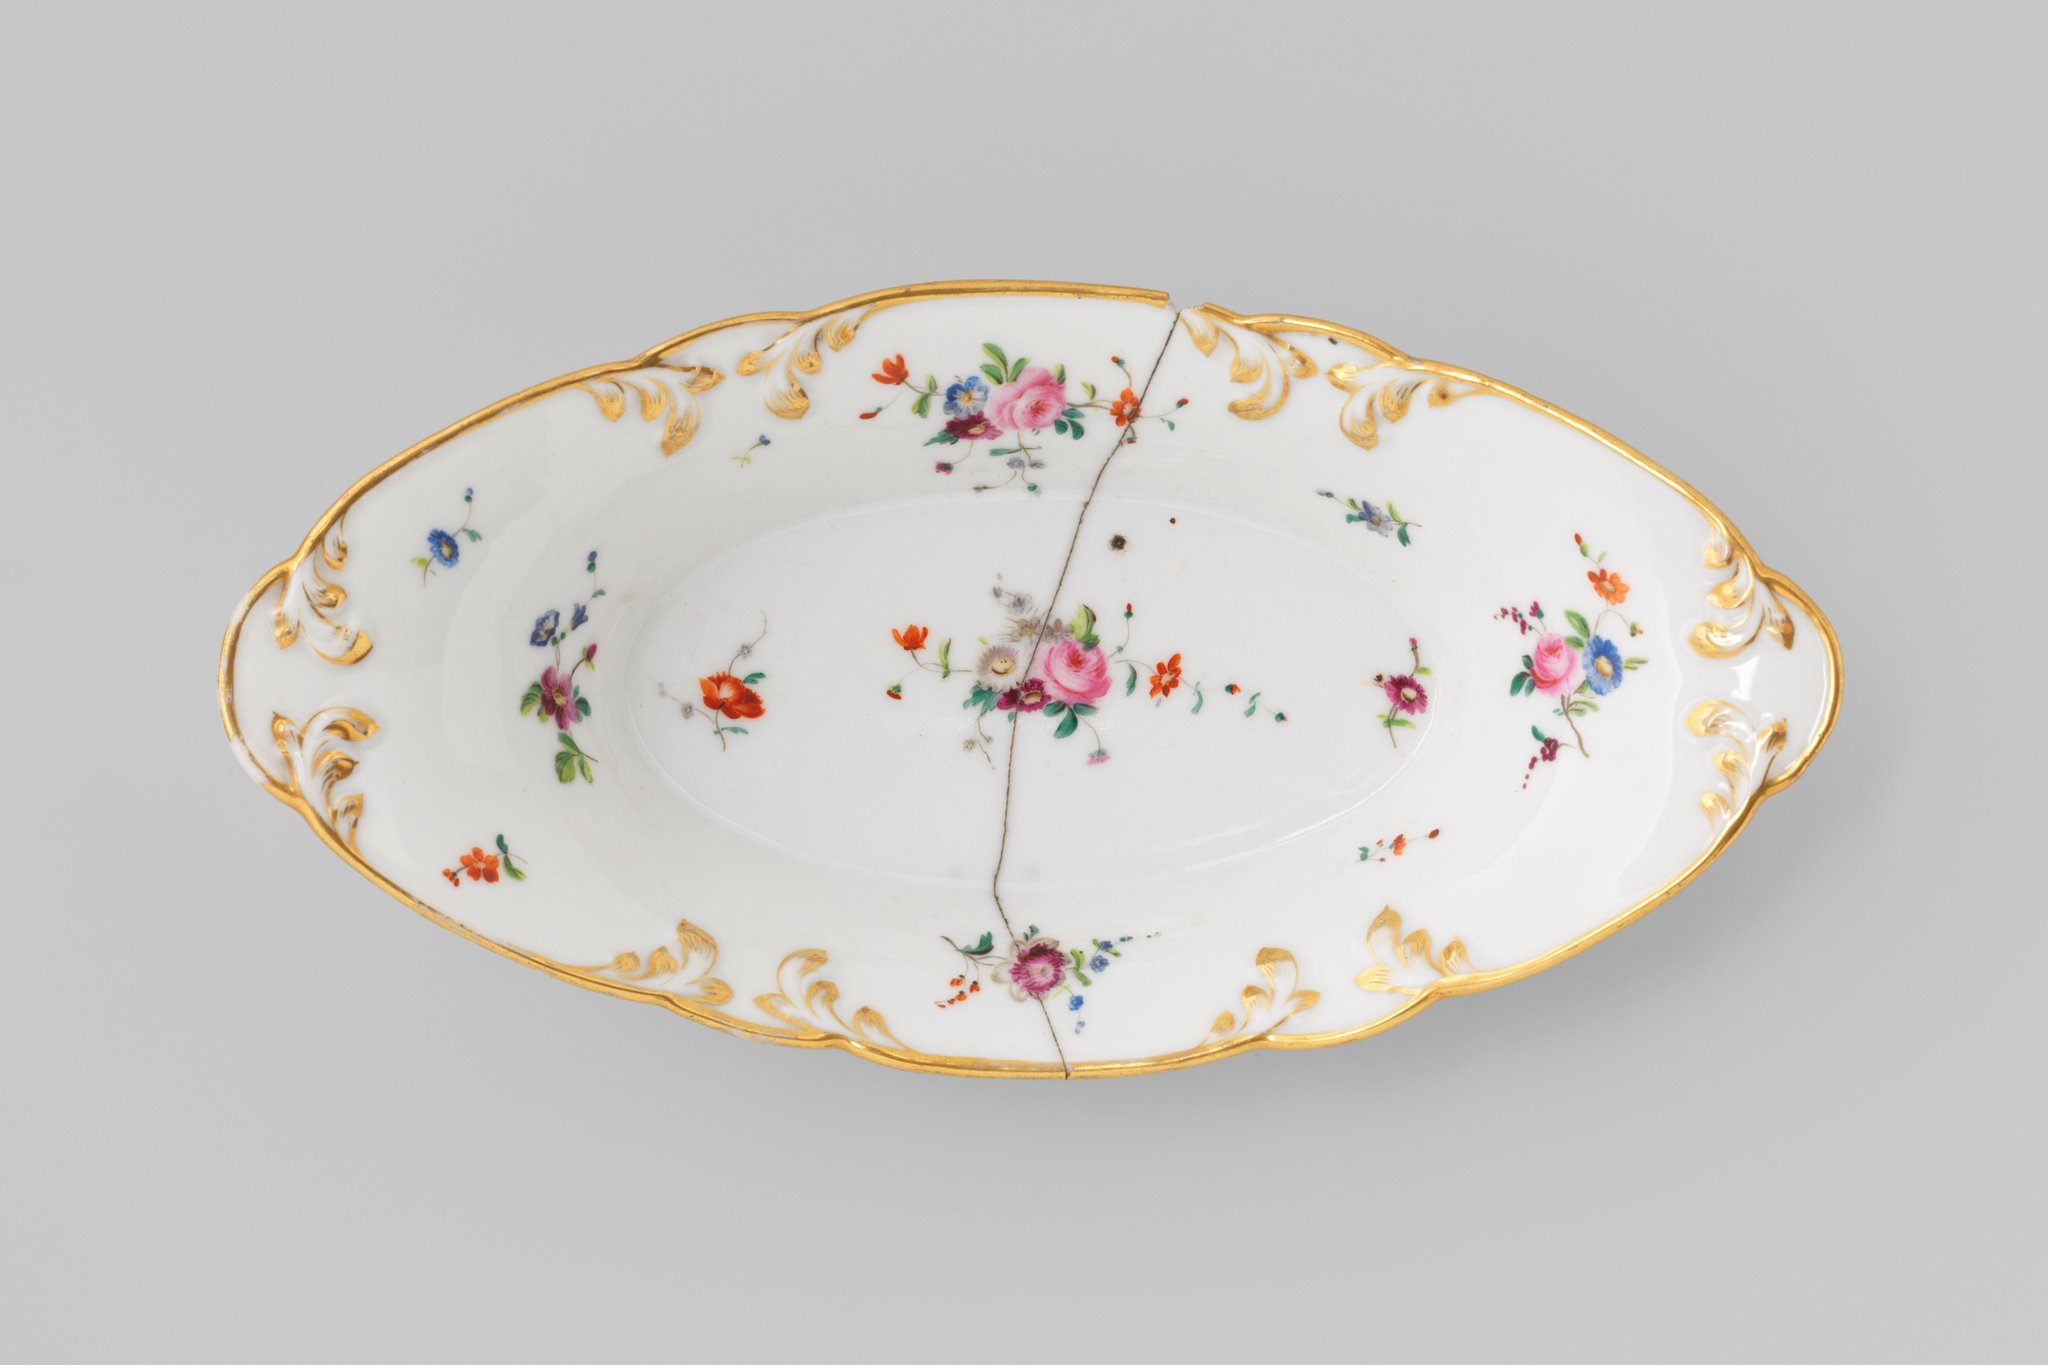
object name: service set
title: Dish with bouquets and flower sprays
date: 1839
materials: glaze, gold, paint, porcelain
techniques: firing, forming, gilding, turning, vitrification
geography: paris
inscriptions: mark: ‘DENUELLE/ Boulevard St. Denis 18/ à Paris’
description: Ovale schaal van porselein met een gelobde rand en de uiteinden spits toelopend, beschilderd op het glazuur in blauw, rood, roze, groen, geel, paars, zwart en goud. Op het plat, de binnen- en buitenwand boeketten van verschillende bloemen en strooibloemen. Vanuit de gelobde, gouden rand, op de binnenwand gemodelleerde bladranken in reliëf, aangezet met goud. Gouden lijn boven de voet. Gemerkt op de onderzijde met 'DENUELLE/ Boulevard St. Denis 18/ à Paris'. Gerestaureerd met twee krammen.